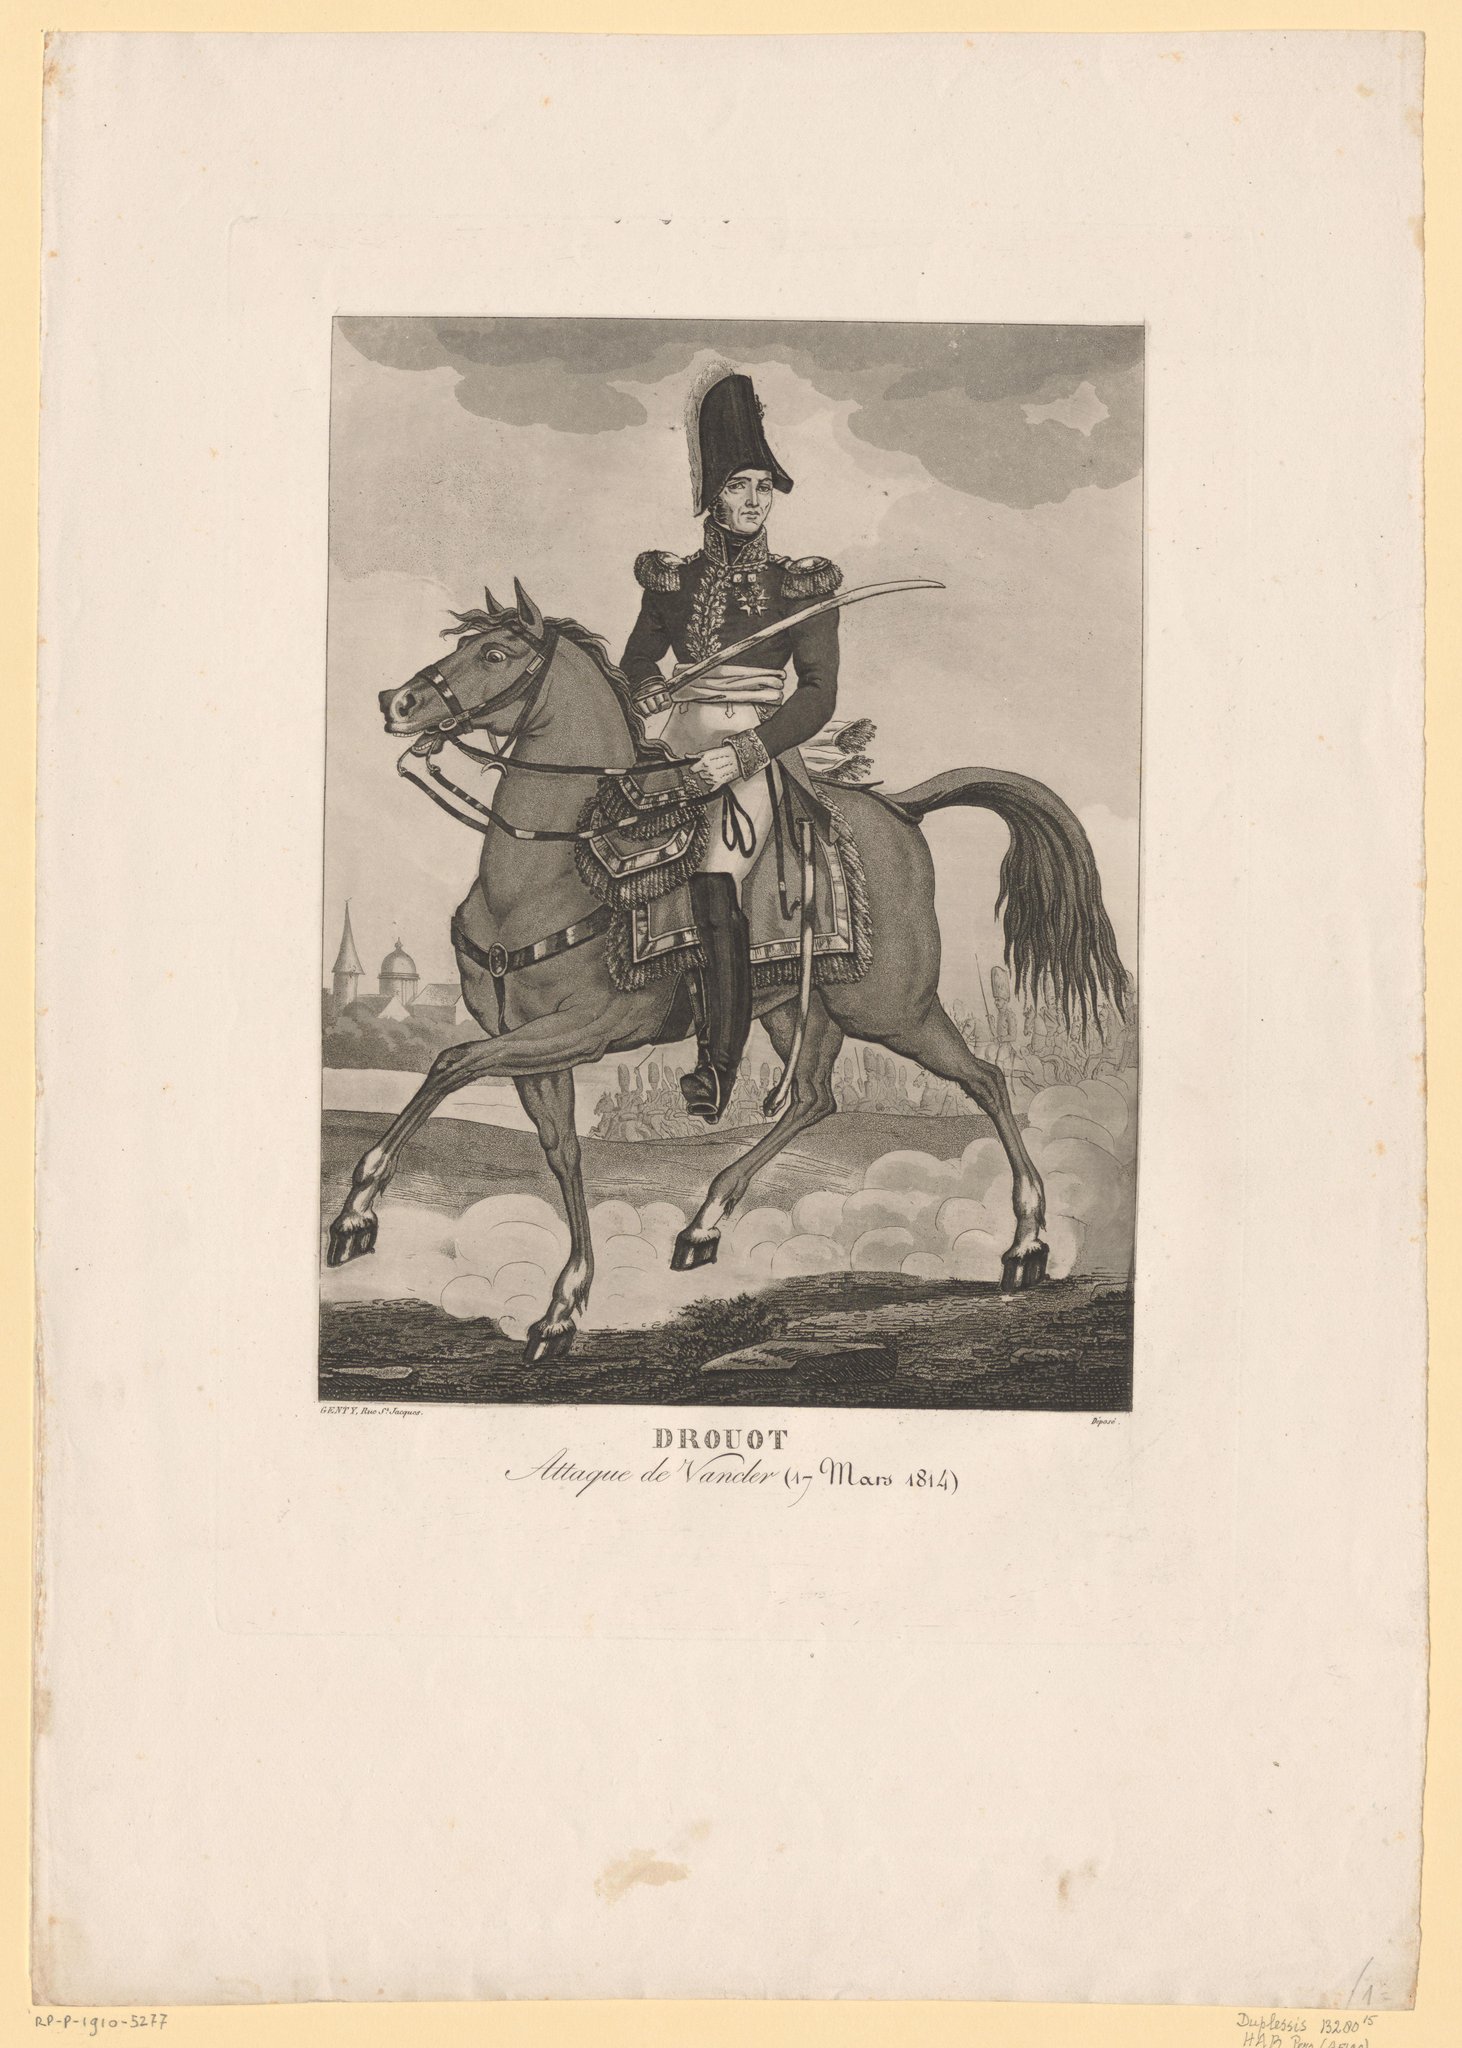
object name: print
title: Ruiterportret van Antoine Drouot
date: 1822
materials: paper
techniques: aquatint, engraving, etching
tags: riding a horse, ass, or mule; rider, horseman, historical persons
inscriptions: collector's mark: Lugt 2228